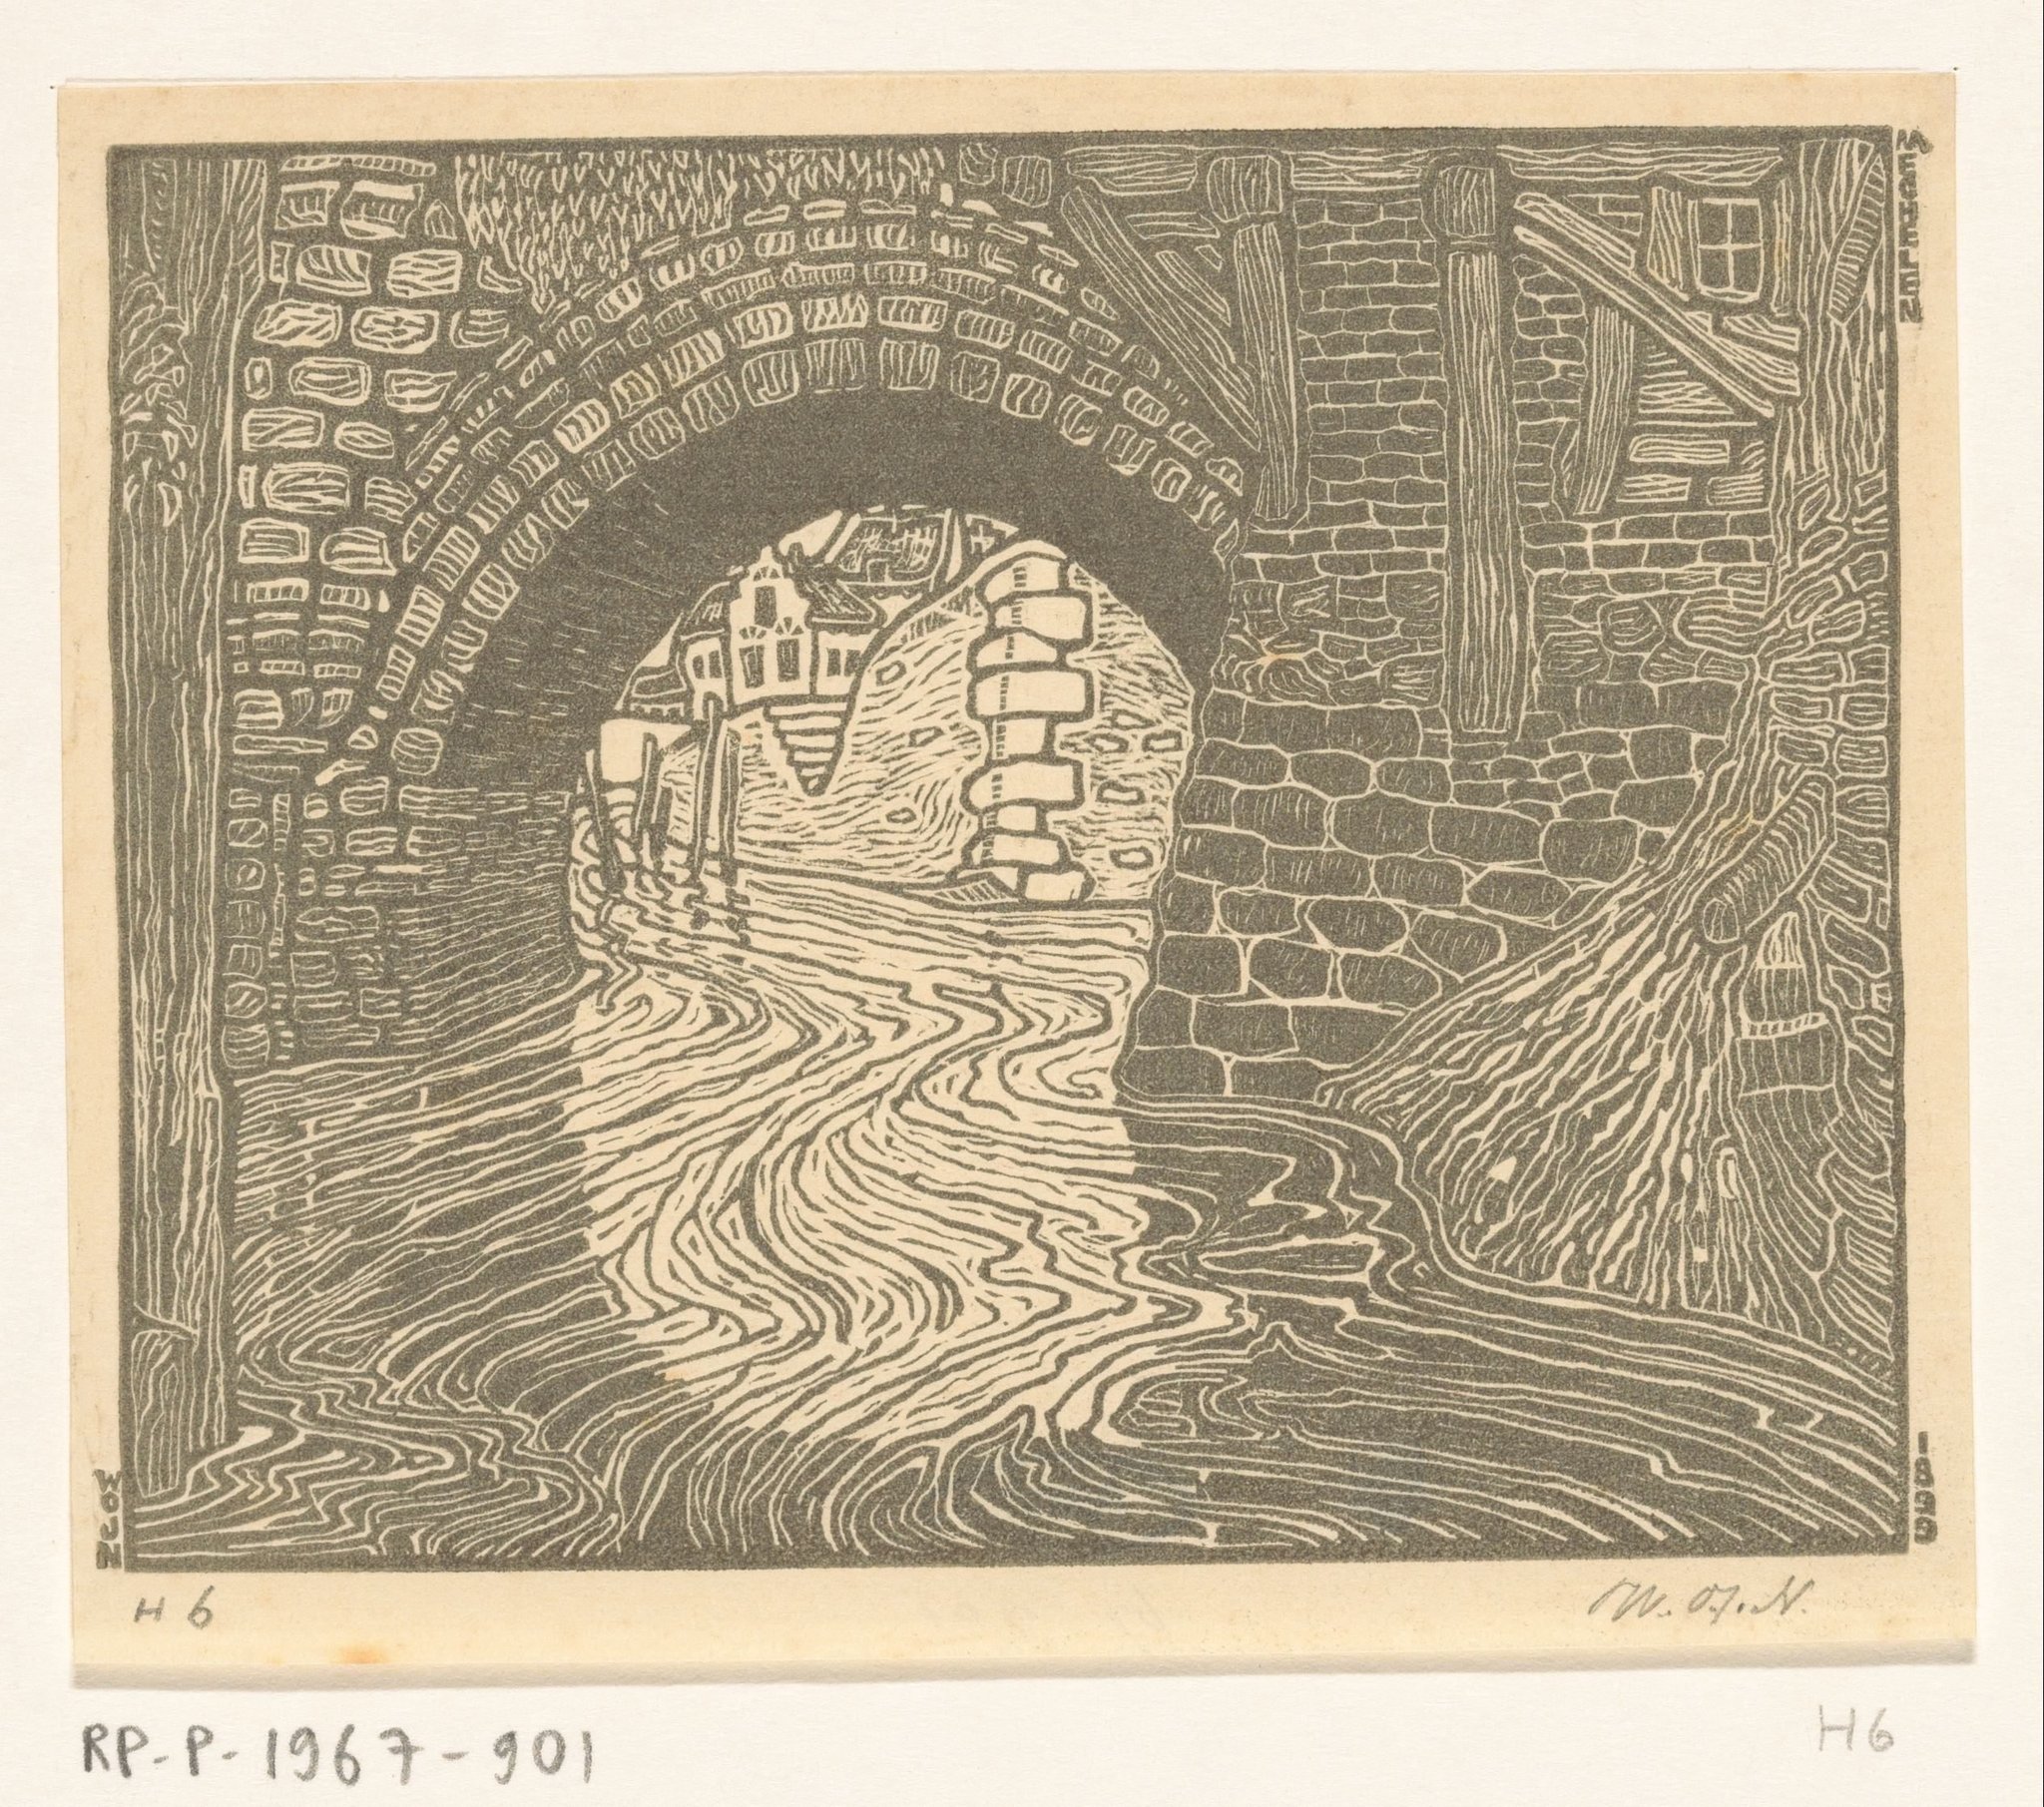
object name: print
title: Brug te Mechelen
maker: wijnand otto jan nieuwenkamp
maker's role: draughtsman, print maker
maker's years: 1874-1950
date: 1811-1899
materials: paper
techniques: woodcut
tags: bridge in city across river, canal, etc., mechelen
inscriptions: collector's mark: Lugt 2228, collector's mark: Lugt 2760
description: Een stenen brug boven het water in Mechelen. Onder de brug door zicht op een wal met huizen.